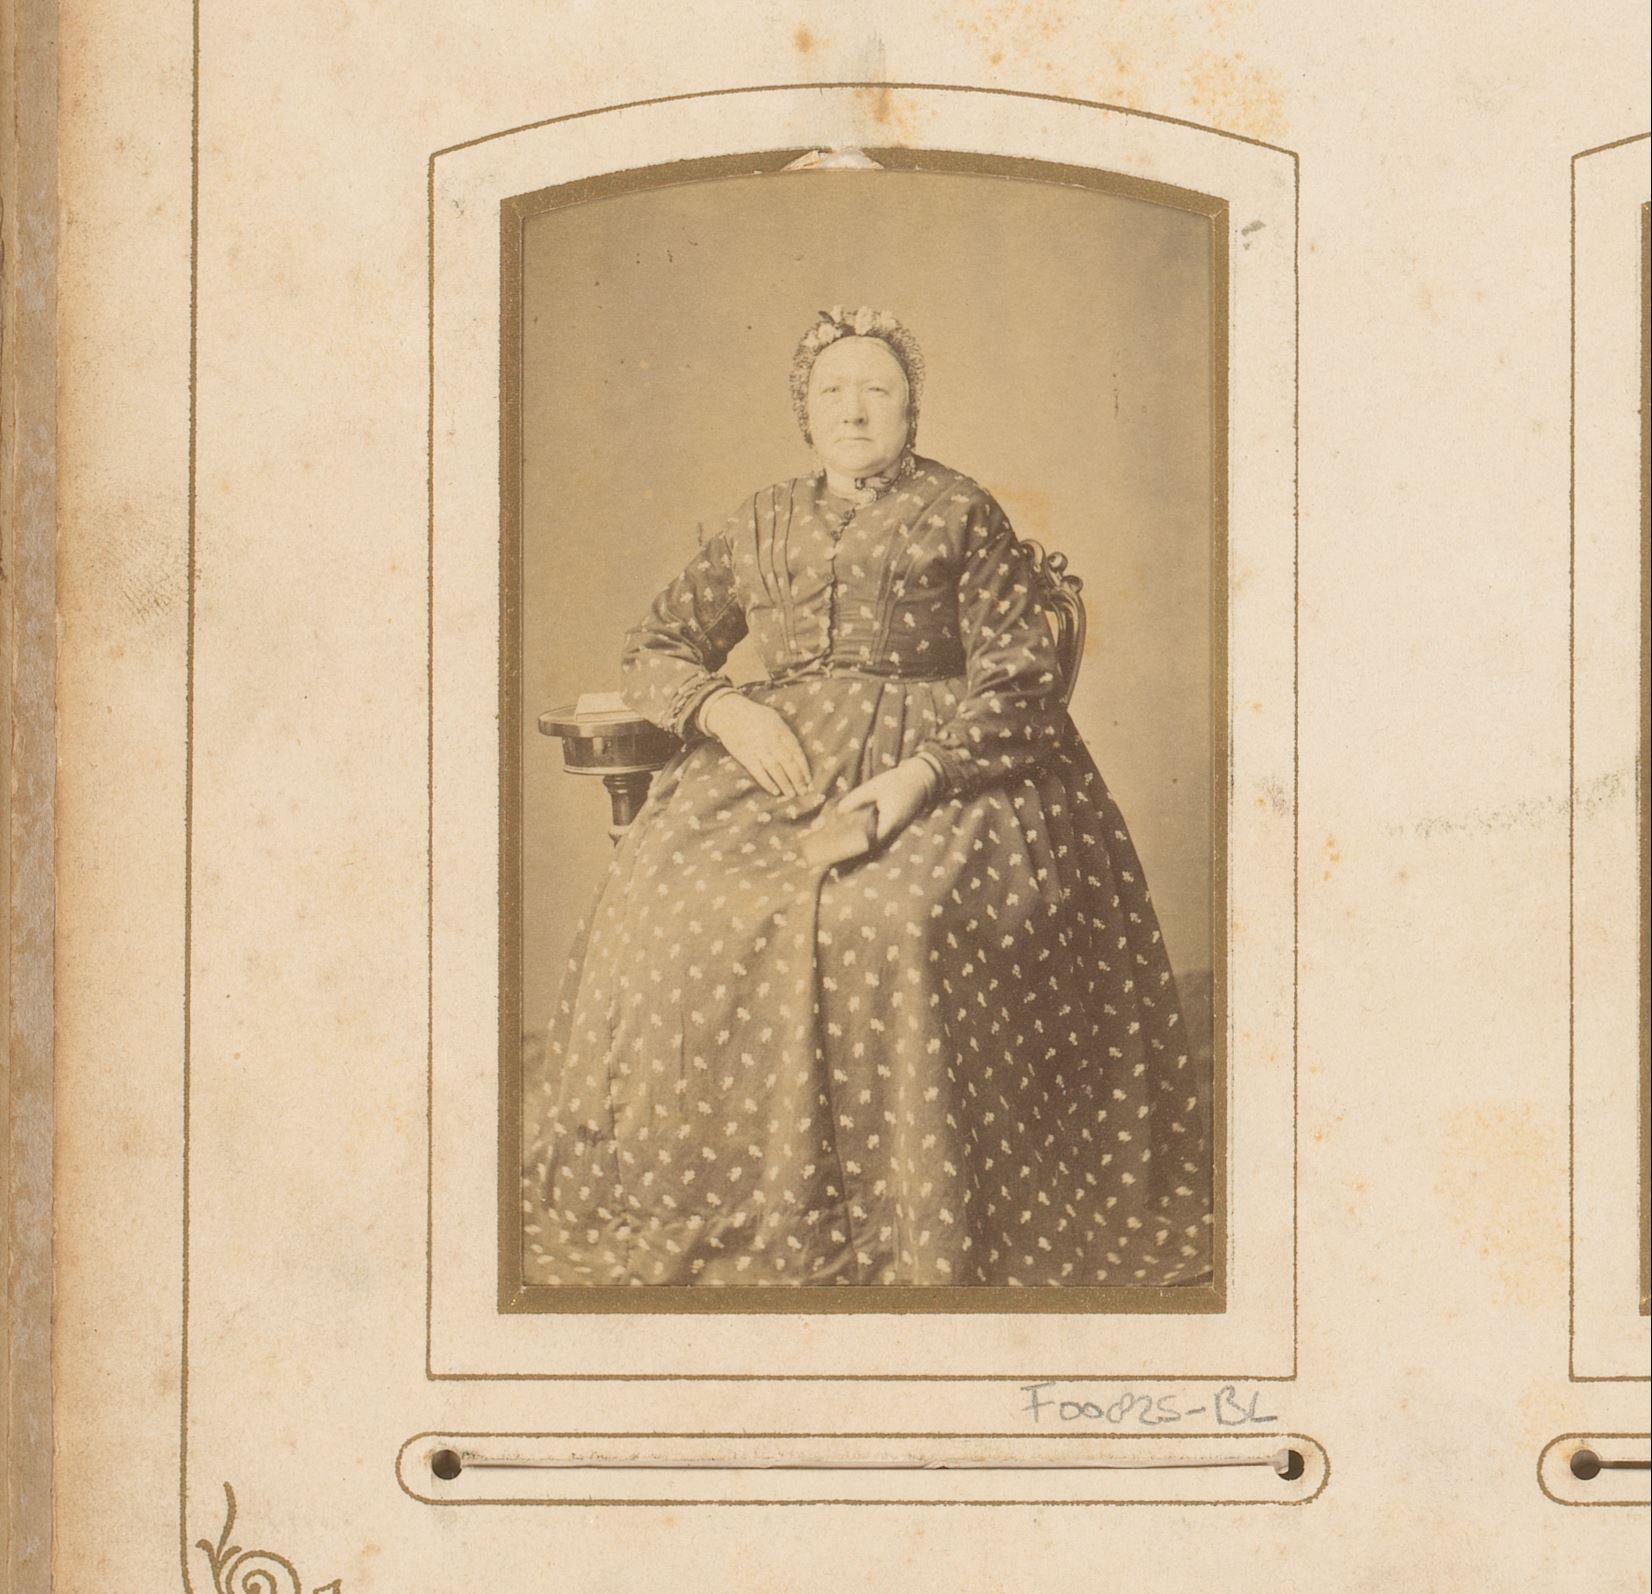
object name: album leaf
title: Portret van een zittende vrouw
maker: jan george mulder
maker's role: fotograaf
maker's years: 1816-1895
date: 1865-1887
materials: cardboard, photographic support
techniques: albumen print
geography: haarlem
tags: sitting figure - aa - female human figure, historical persons - bb - woman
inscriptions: inscription: ‘Photographisch/ Atelier/ van/ J. G. Mulder./ Lange Bagijnestraat/ Haarlem./ De plaat blijft tot nabestelling bewaard.’